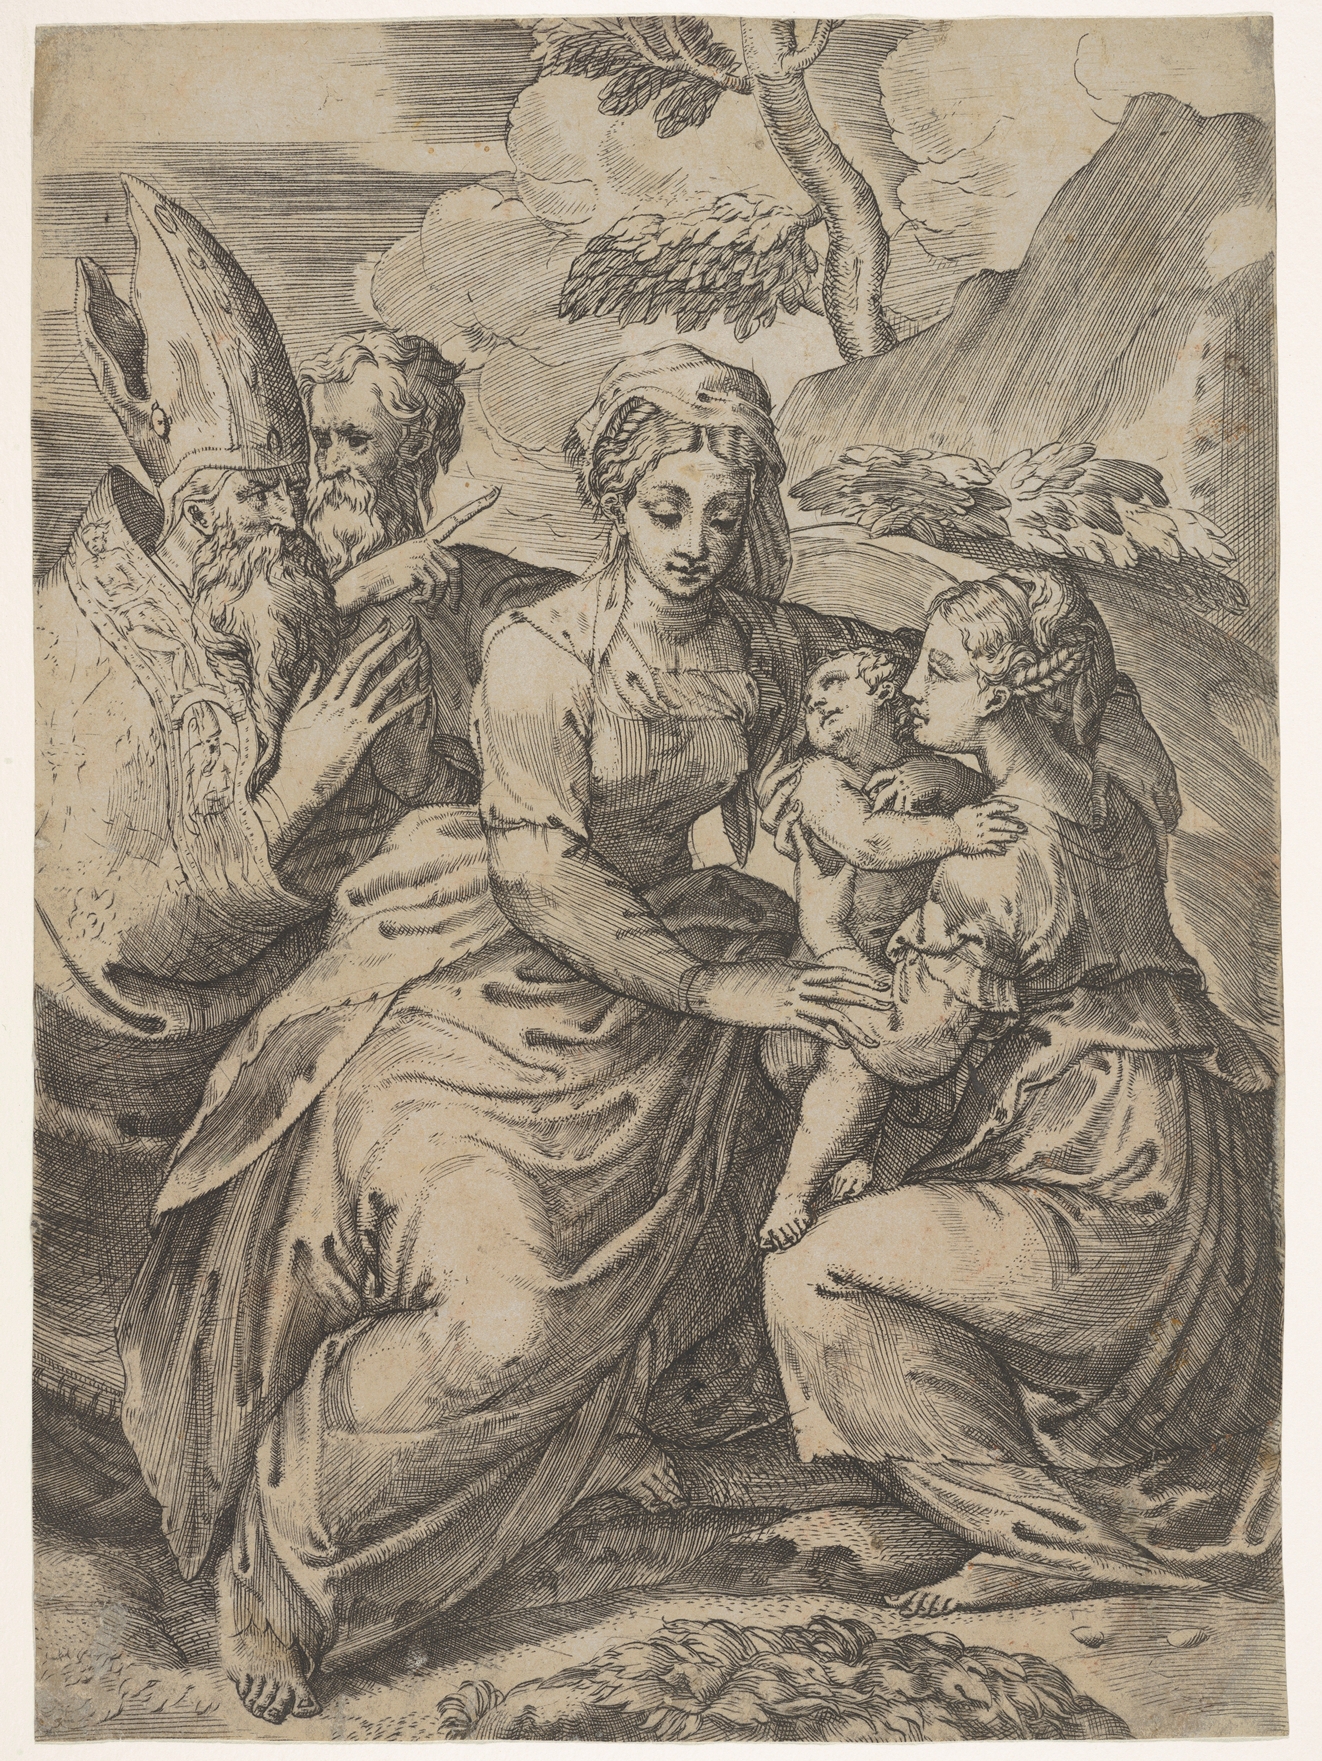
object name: print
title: Madonna and Child with Saints (after Parmigianino)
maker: battista angolo del moro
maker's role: artist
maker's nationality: italian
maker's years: 1515-1573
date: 1515-1573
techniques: engraving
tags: madonna and child,saints